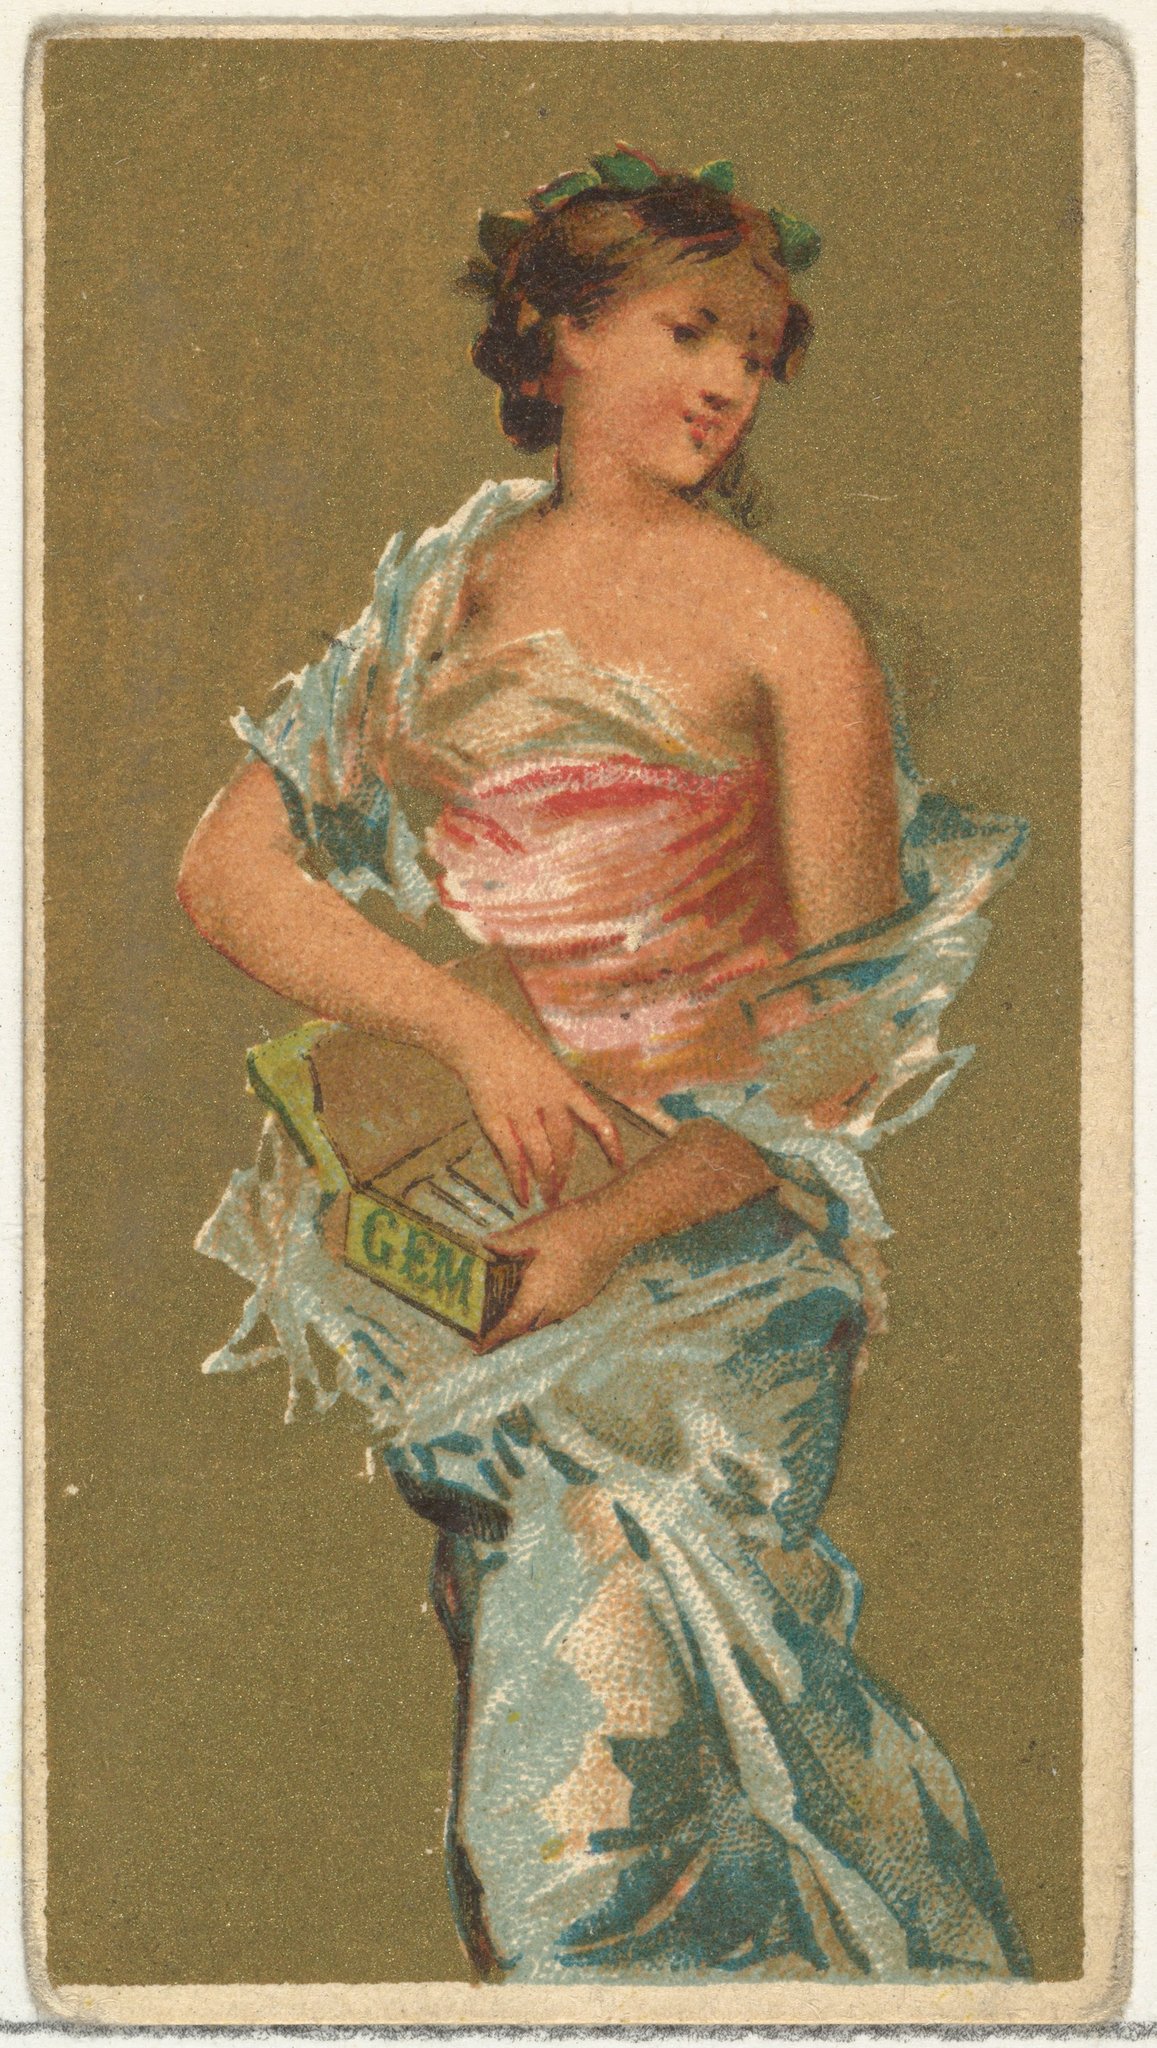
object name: print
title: From the Girls and Children series (N65) promoting Richmond Gem Cigarettes for Allen & Ginter brand tobacco products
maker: allen & ginter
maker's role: publisher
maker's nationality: american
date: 1886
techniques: color lithograph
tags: girls